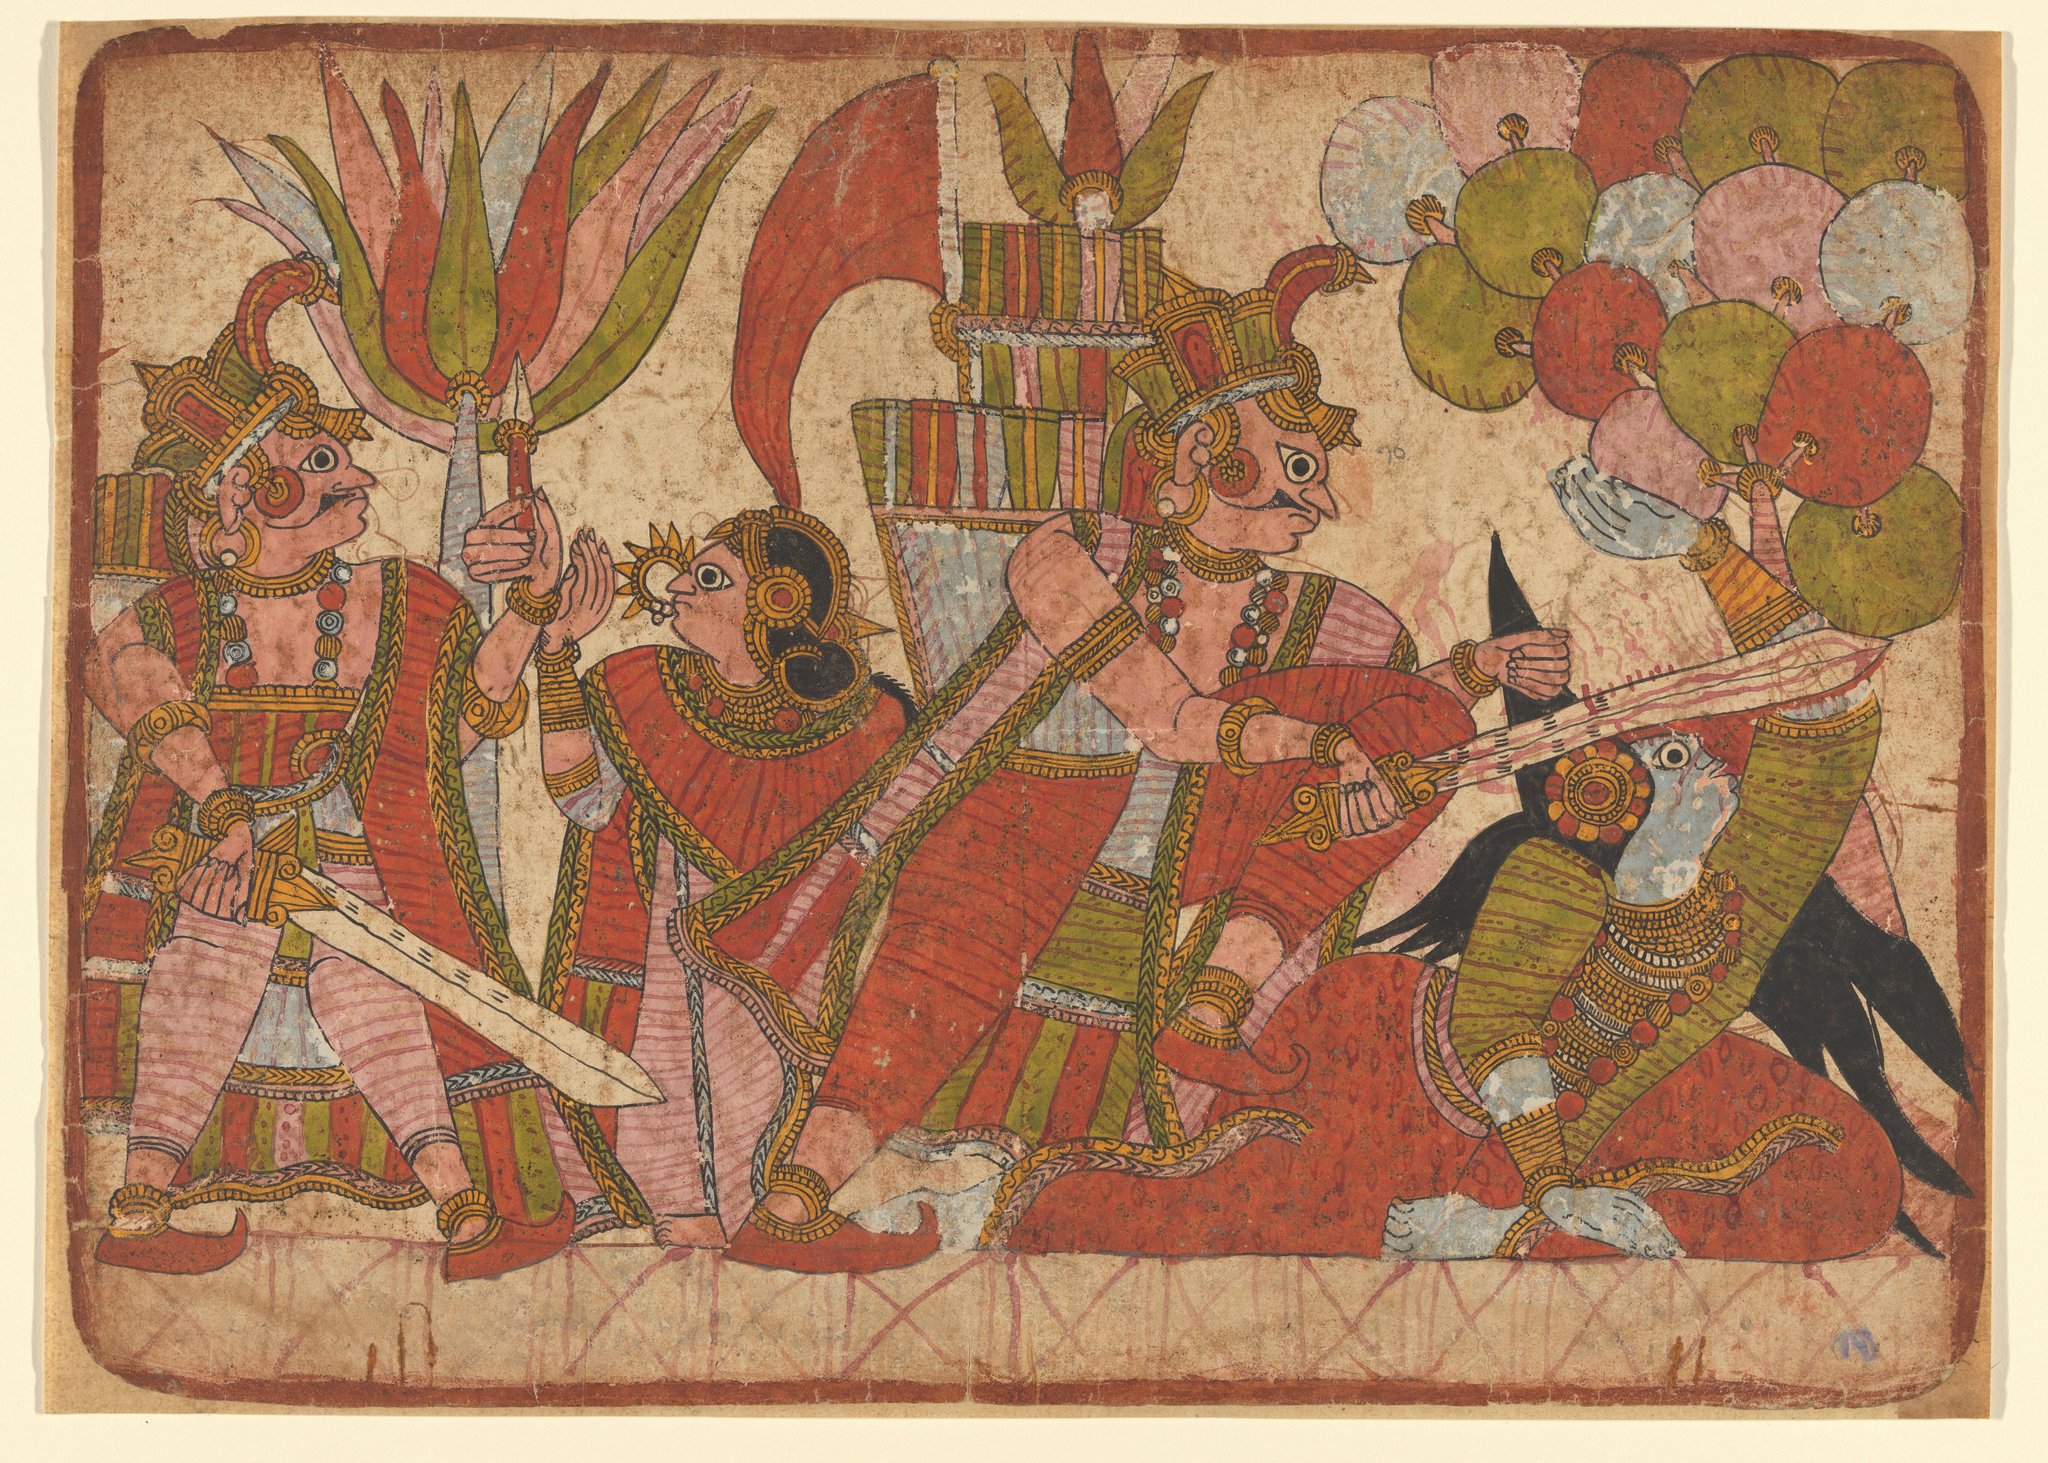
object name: drawing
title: ‘Paithan’ (Chitrakathi) narrative painting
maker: Anonymous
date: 1800-1899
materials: paper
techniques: brush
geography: india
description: De demoness Surpanakha fell in love with Lakshmana. Two consecutive scenes are shown here. The left side of the painting depicts Surpanakha trying to seduce Lakshmana. On the right, one sees Lakshmana cutting off the nose and the ears of the demoness. Scene from the Ramayana.